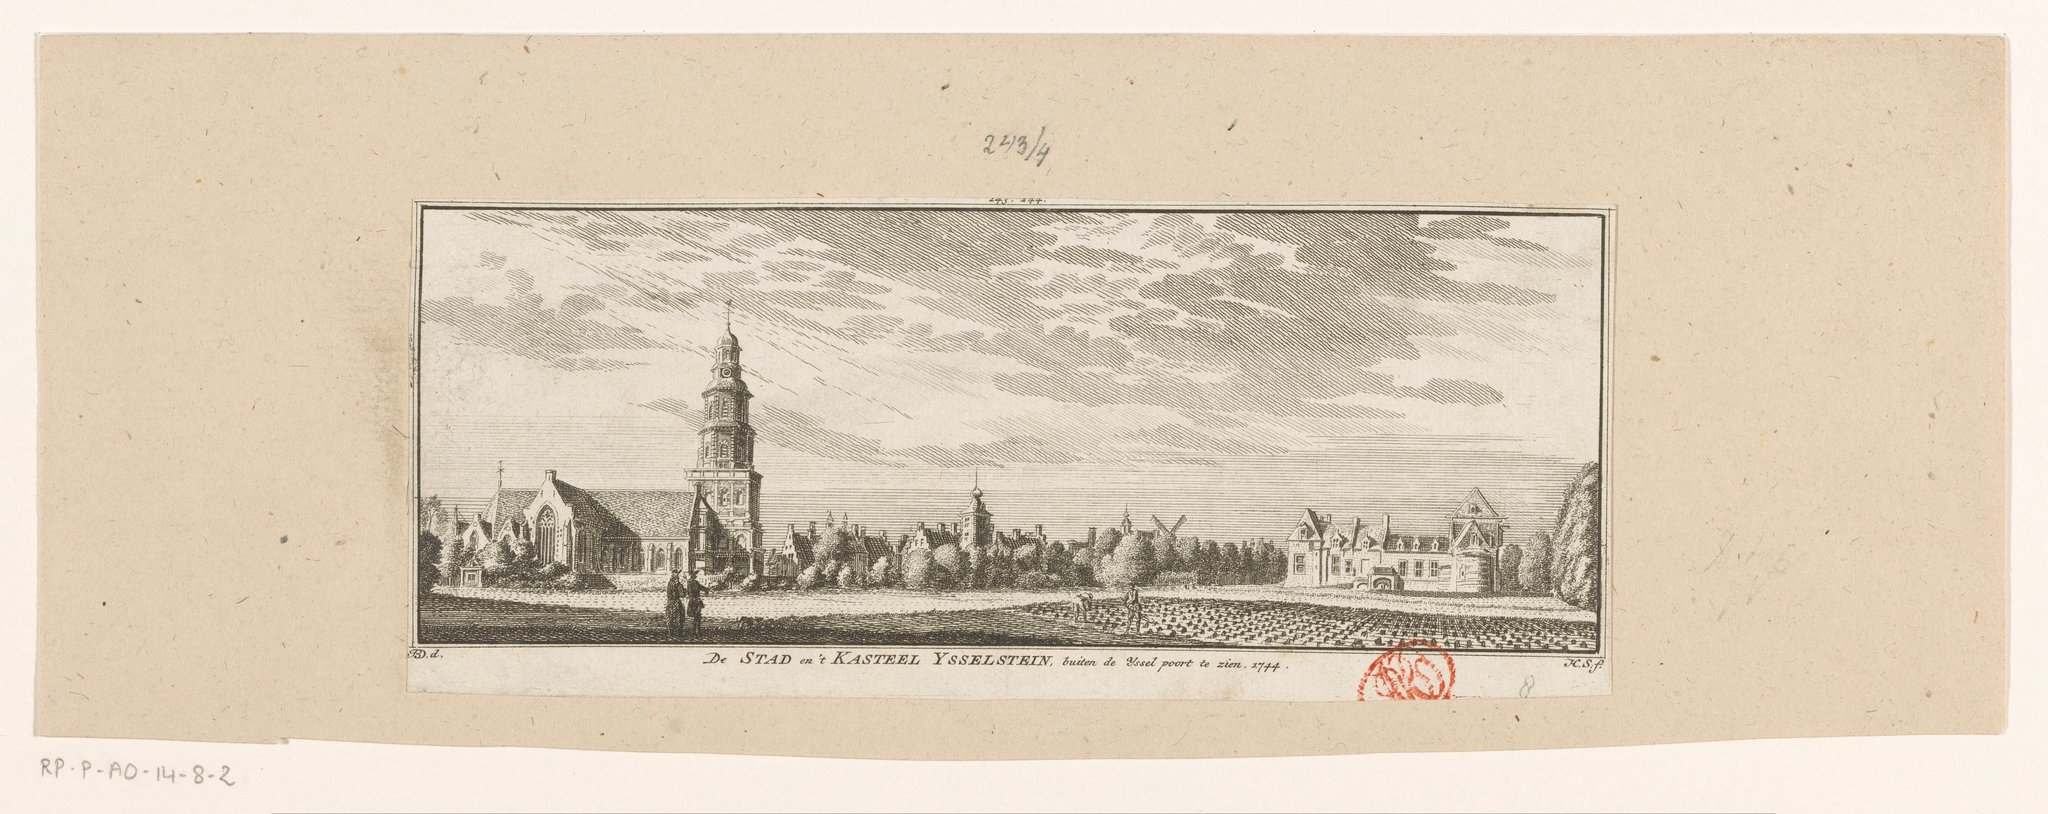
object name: book illustration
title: Gezicht op IJsselstein, 1774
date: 1750-1792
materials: paper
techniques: etching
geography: haarlem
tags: castle, church (exterior), prospect of city, town panorama, silhouette of city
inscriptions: collector's mark: Lugt 195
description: Prent ook gebruikt in: Het verheerlykt Nederland of kabinet van hedendaagsche gezigten van steden, dorpen (…). 9 delen. Amsterdam: Isaak Tirion en weduwe Isaak Tirion, 1745-1774, dl. 3 (1750), ill. 243-244. Of in: Nederlandsche tafereelen; of eene keurige verzameling van negen honderd fraaije gezigten van steden, dorpen, sloten, oudheden (….). 9 delen. Amsterdam: Jan de Groot, 1792, dl. 3, ill. 243-244.